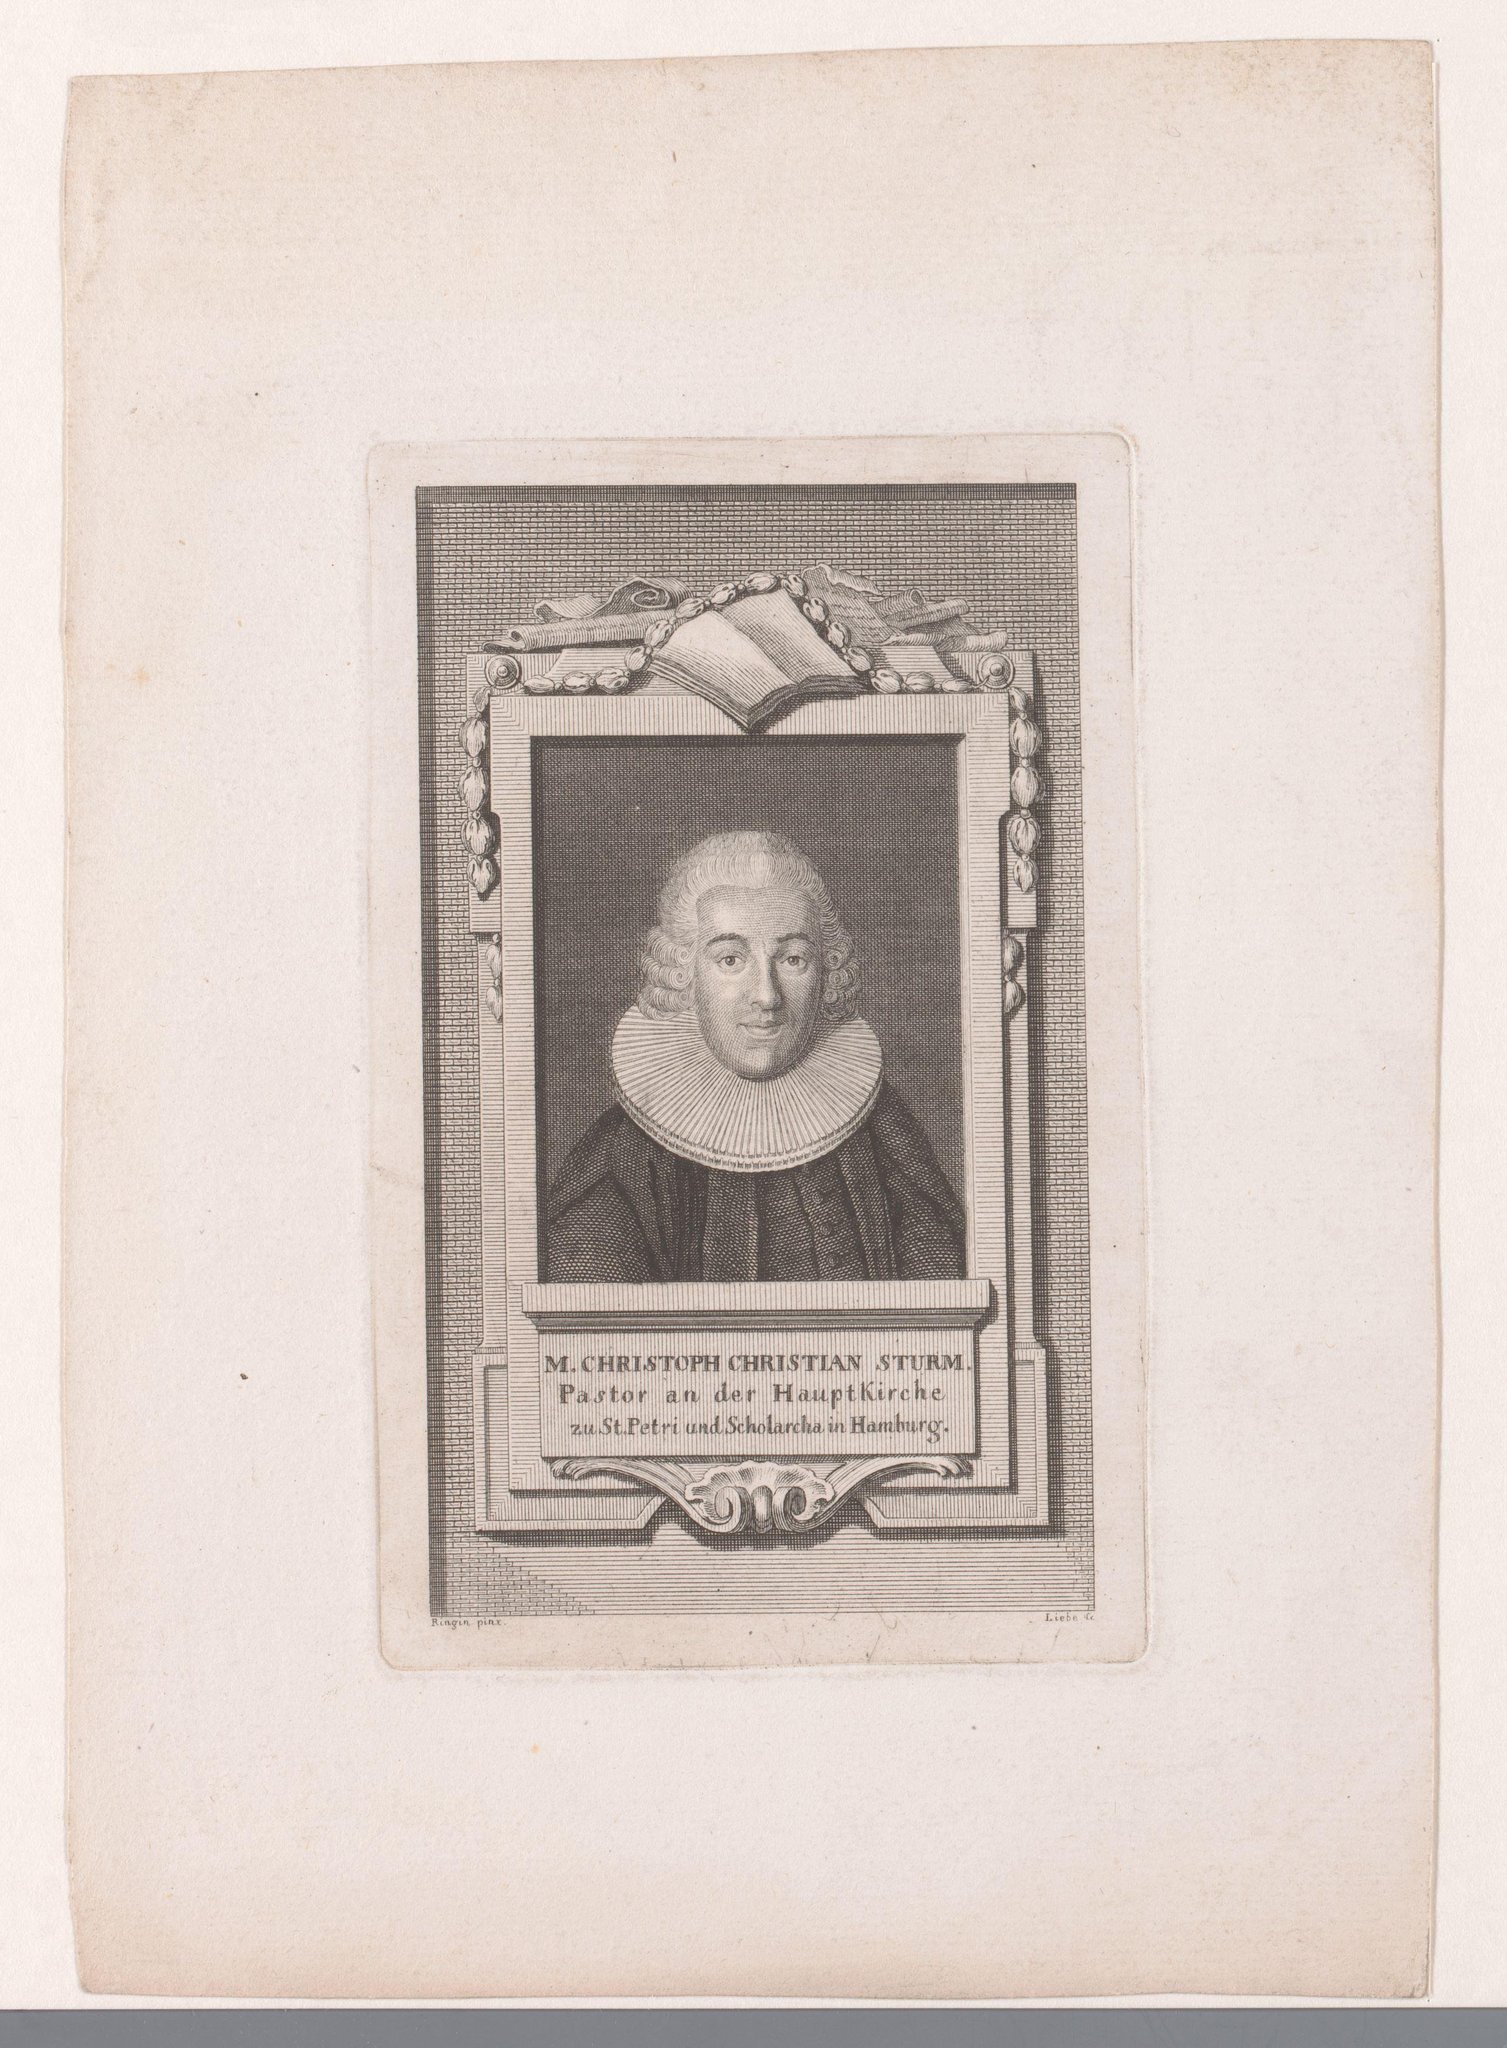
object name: print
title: Portret van Christoph Christian Sturm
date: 1778-1819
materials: paper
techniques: engraving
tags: augsburg, theologian, historical persons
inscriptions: collector's mark: Lugt 2228